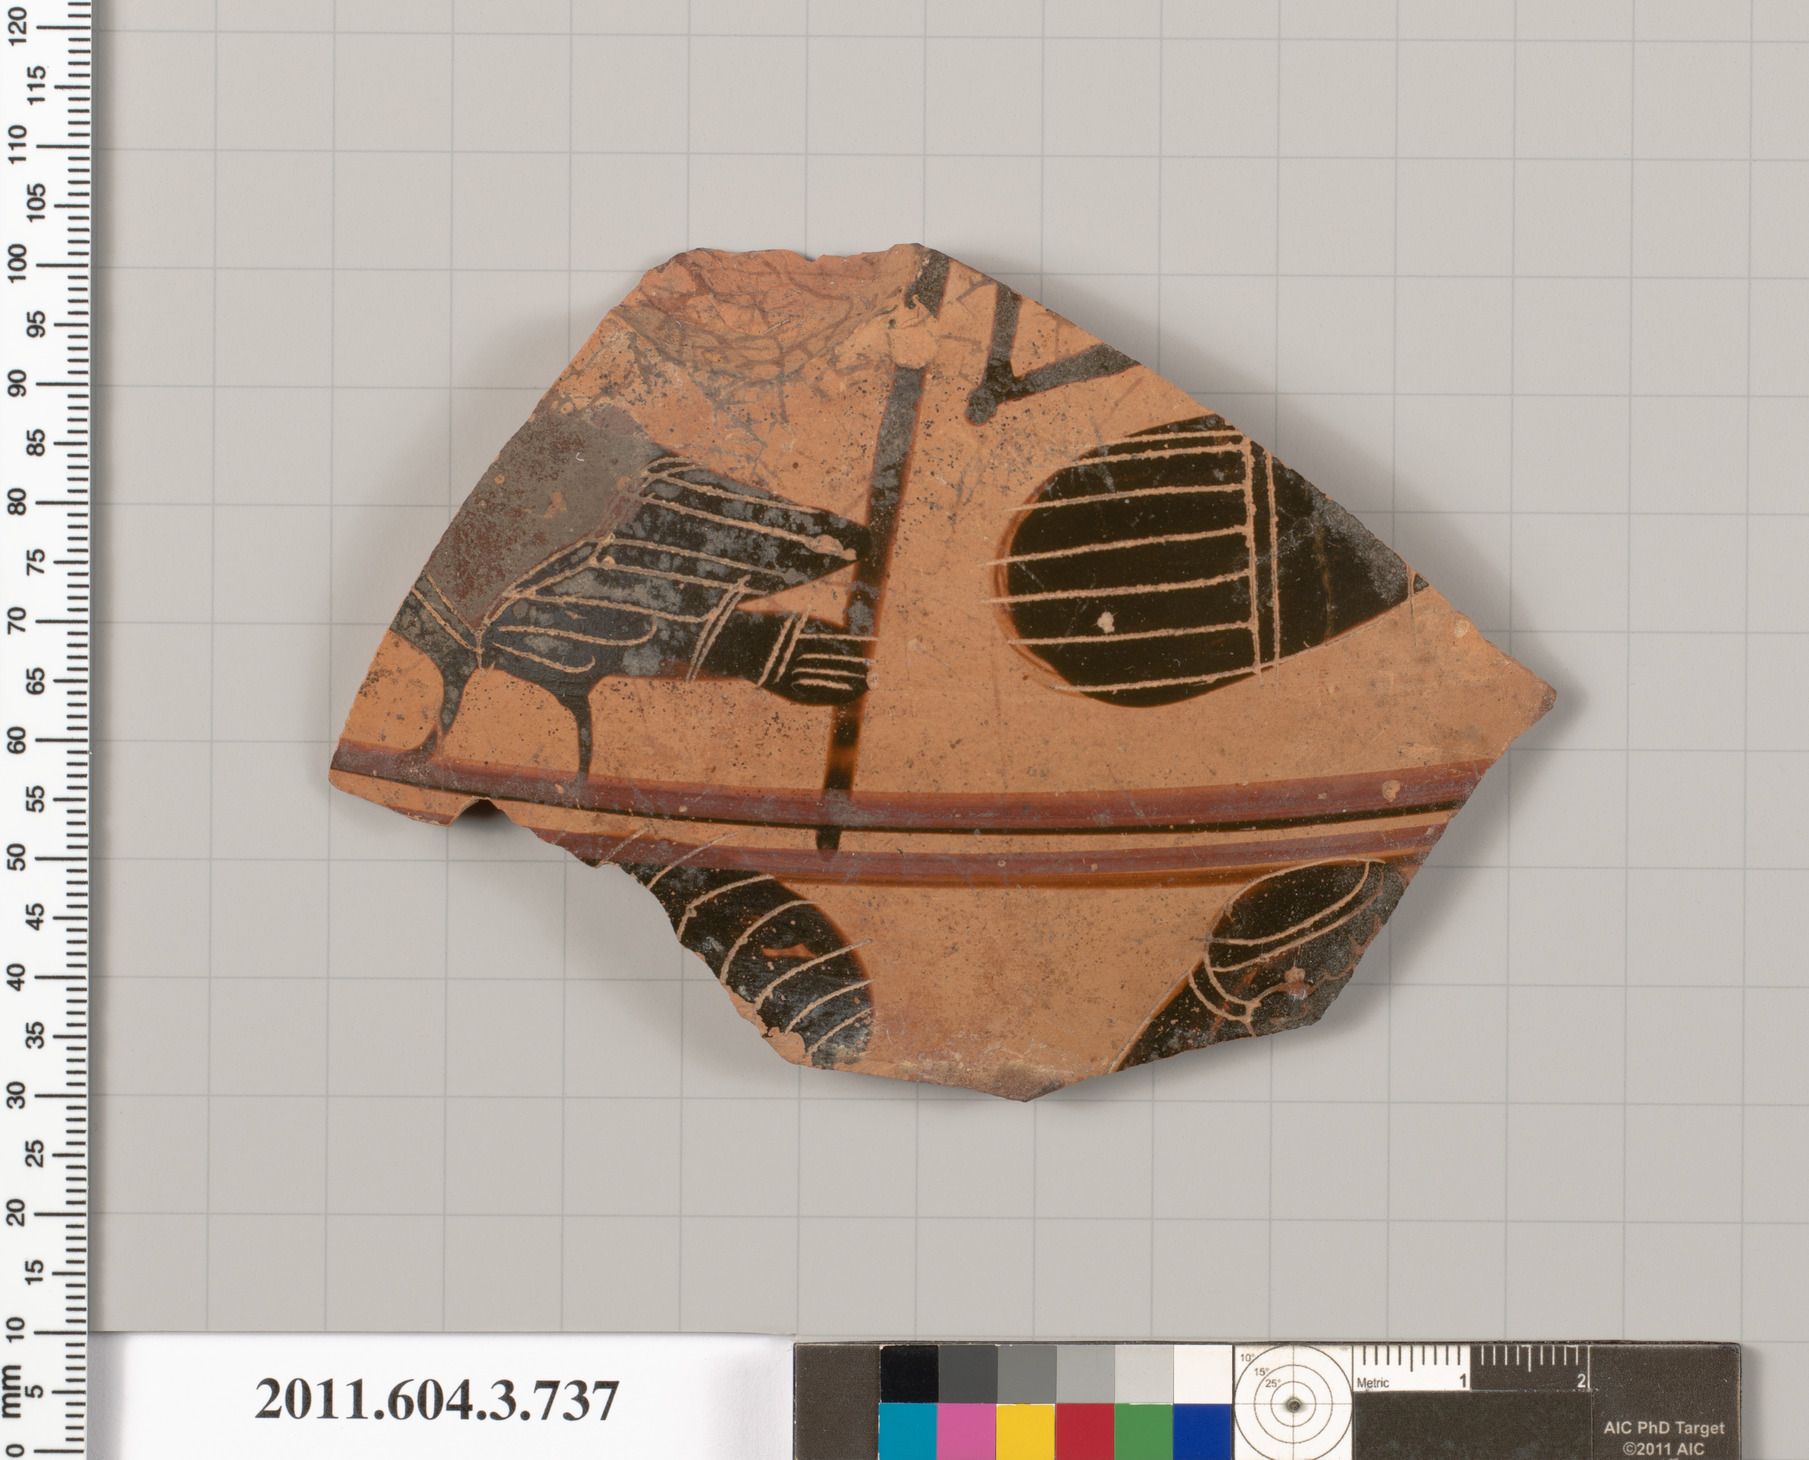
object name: neck amphora, tyrrhenian fragment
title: Terracotta fragment of a neck-amphora (jar)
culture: greek, attic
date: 575-551 BCE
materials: terracotta